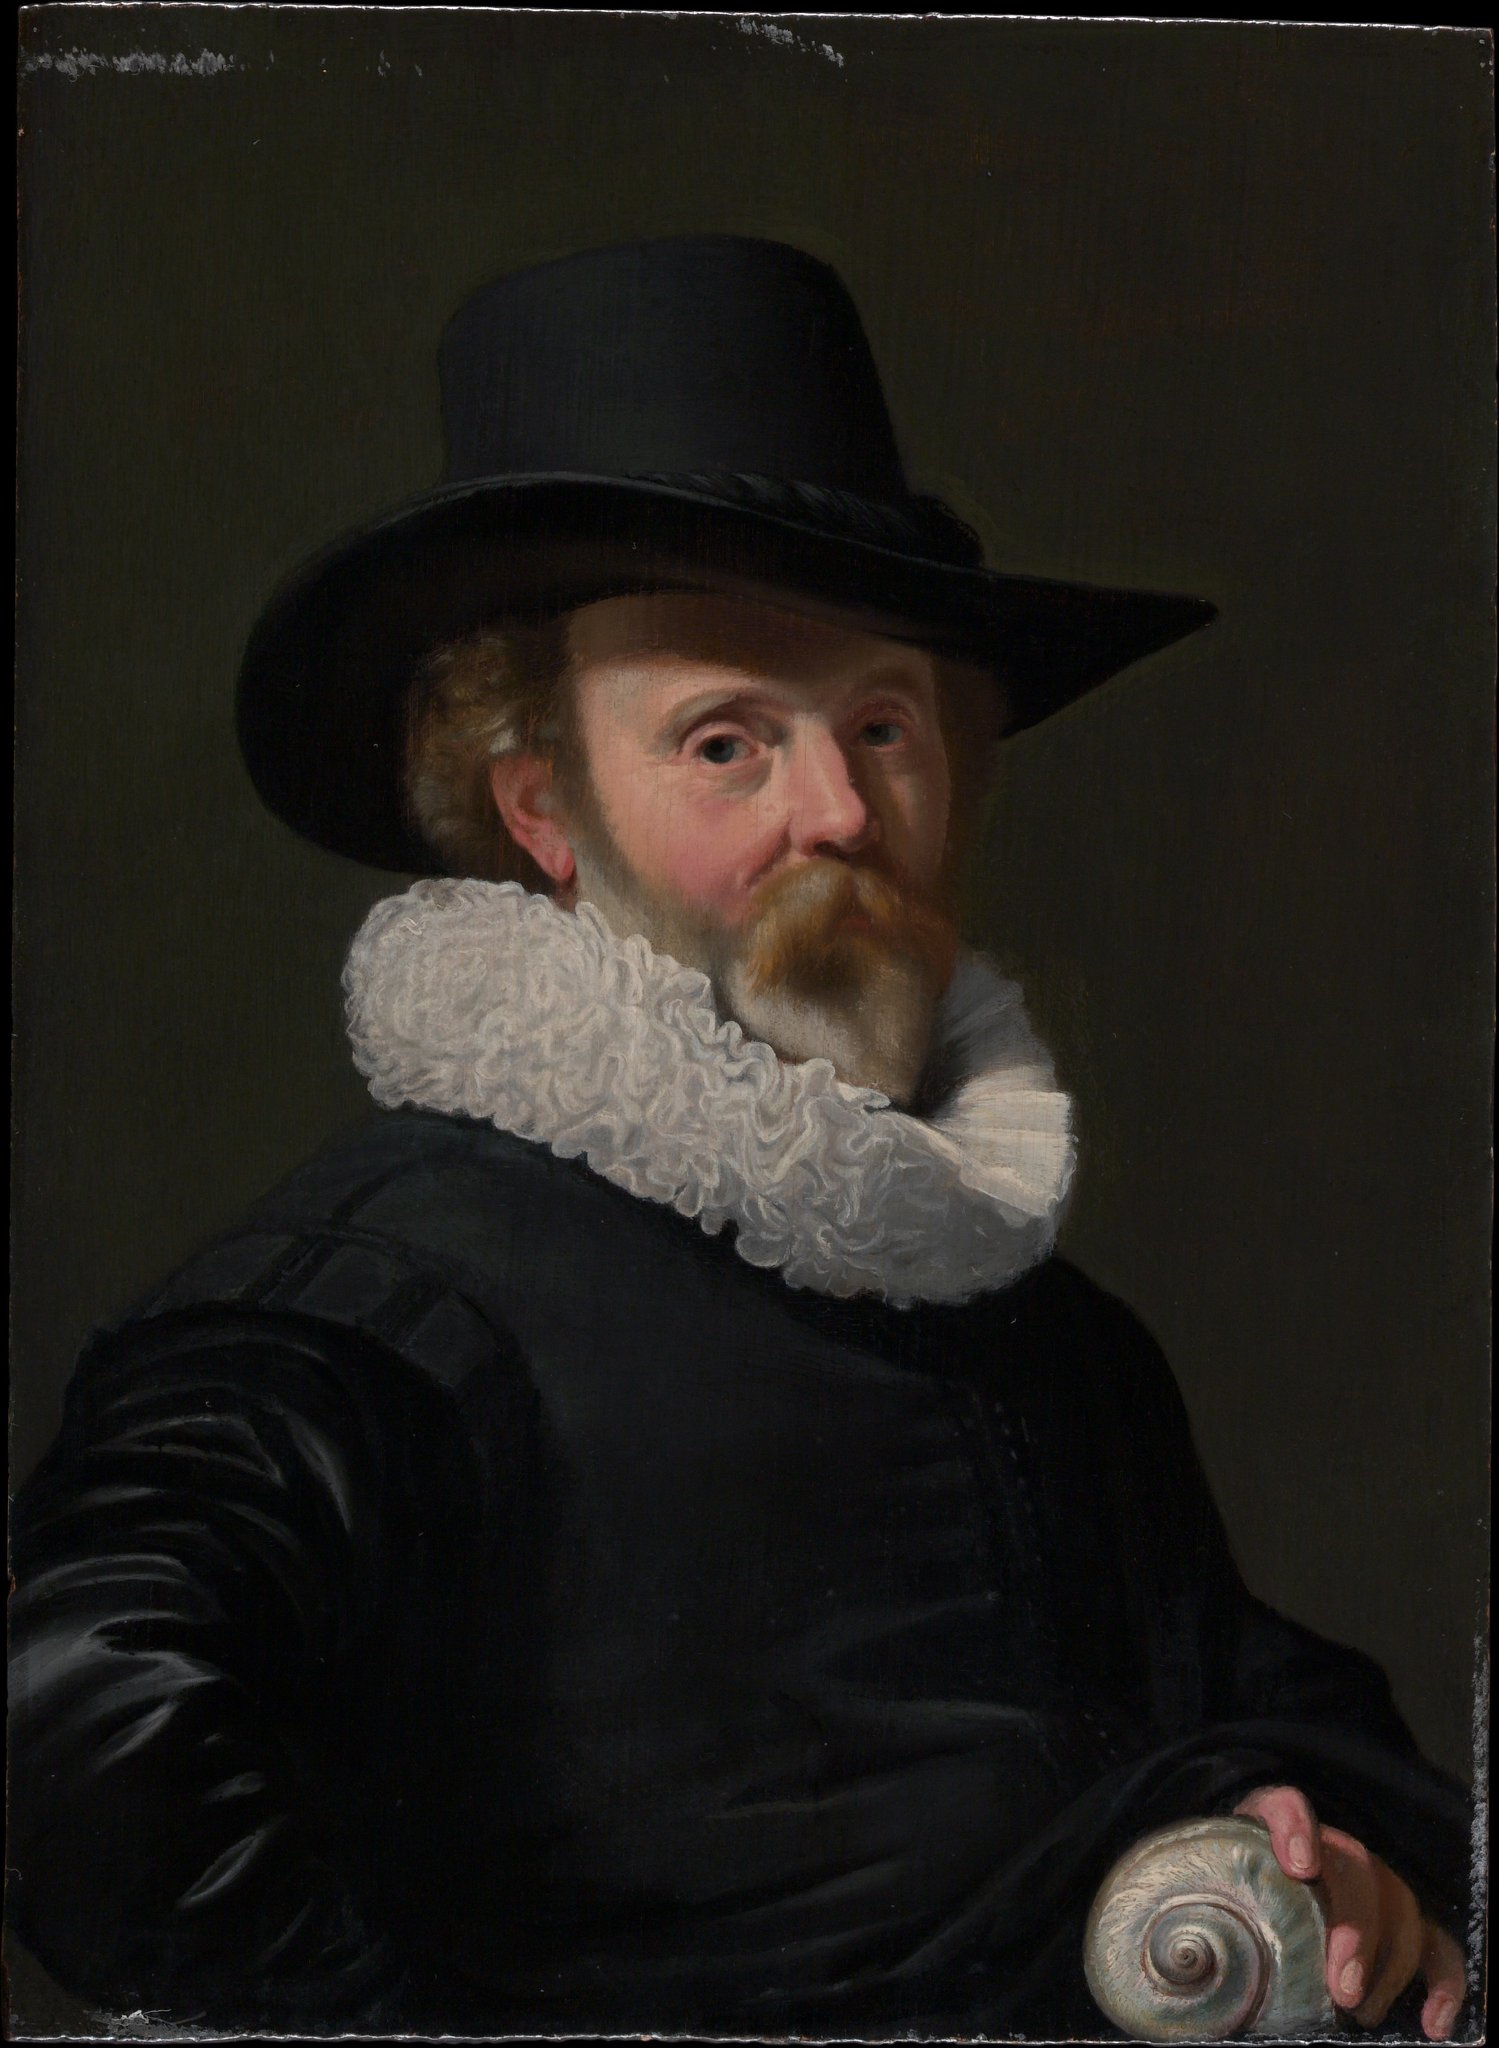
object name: painting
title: Portrait of a Man with a Shell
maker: thomas de keyser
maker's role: artist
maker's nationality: dutch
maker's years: 1596-1667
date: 1625-1626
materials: oil, wood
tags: men,portraits,shells